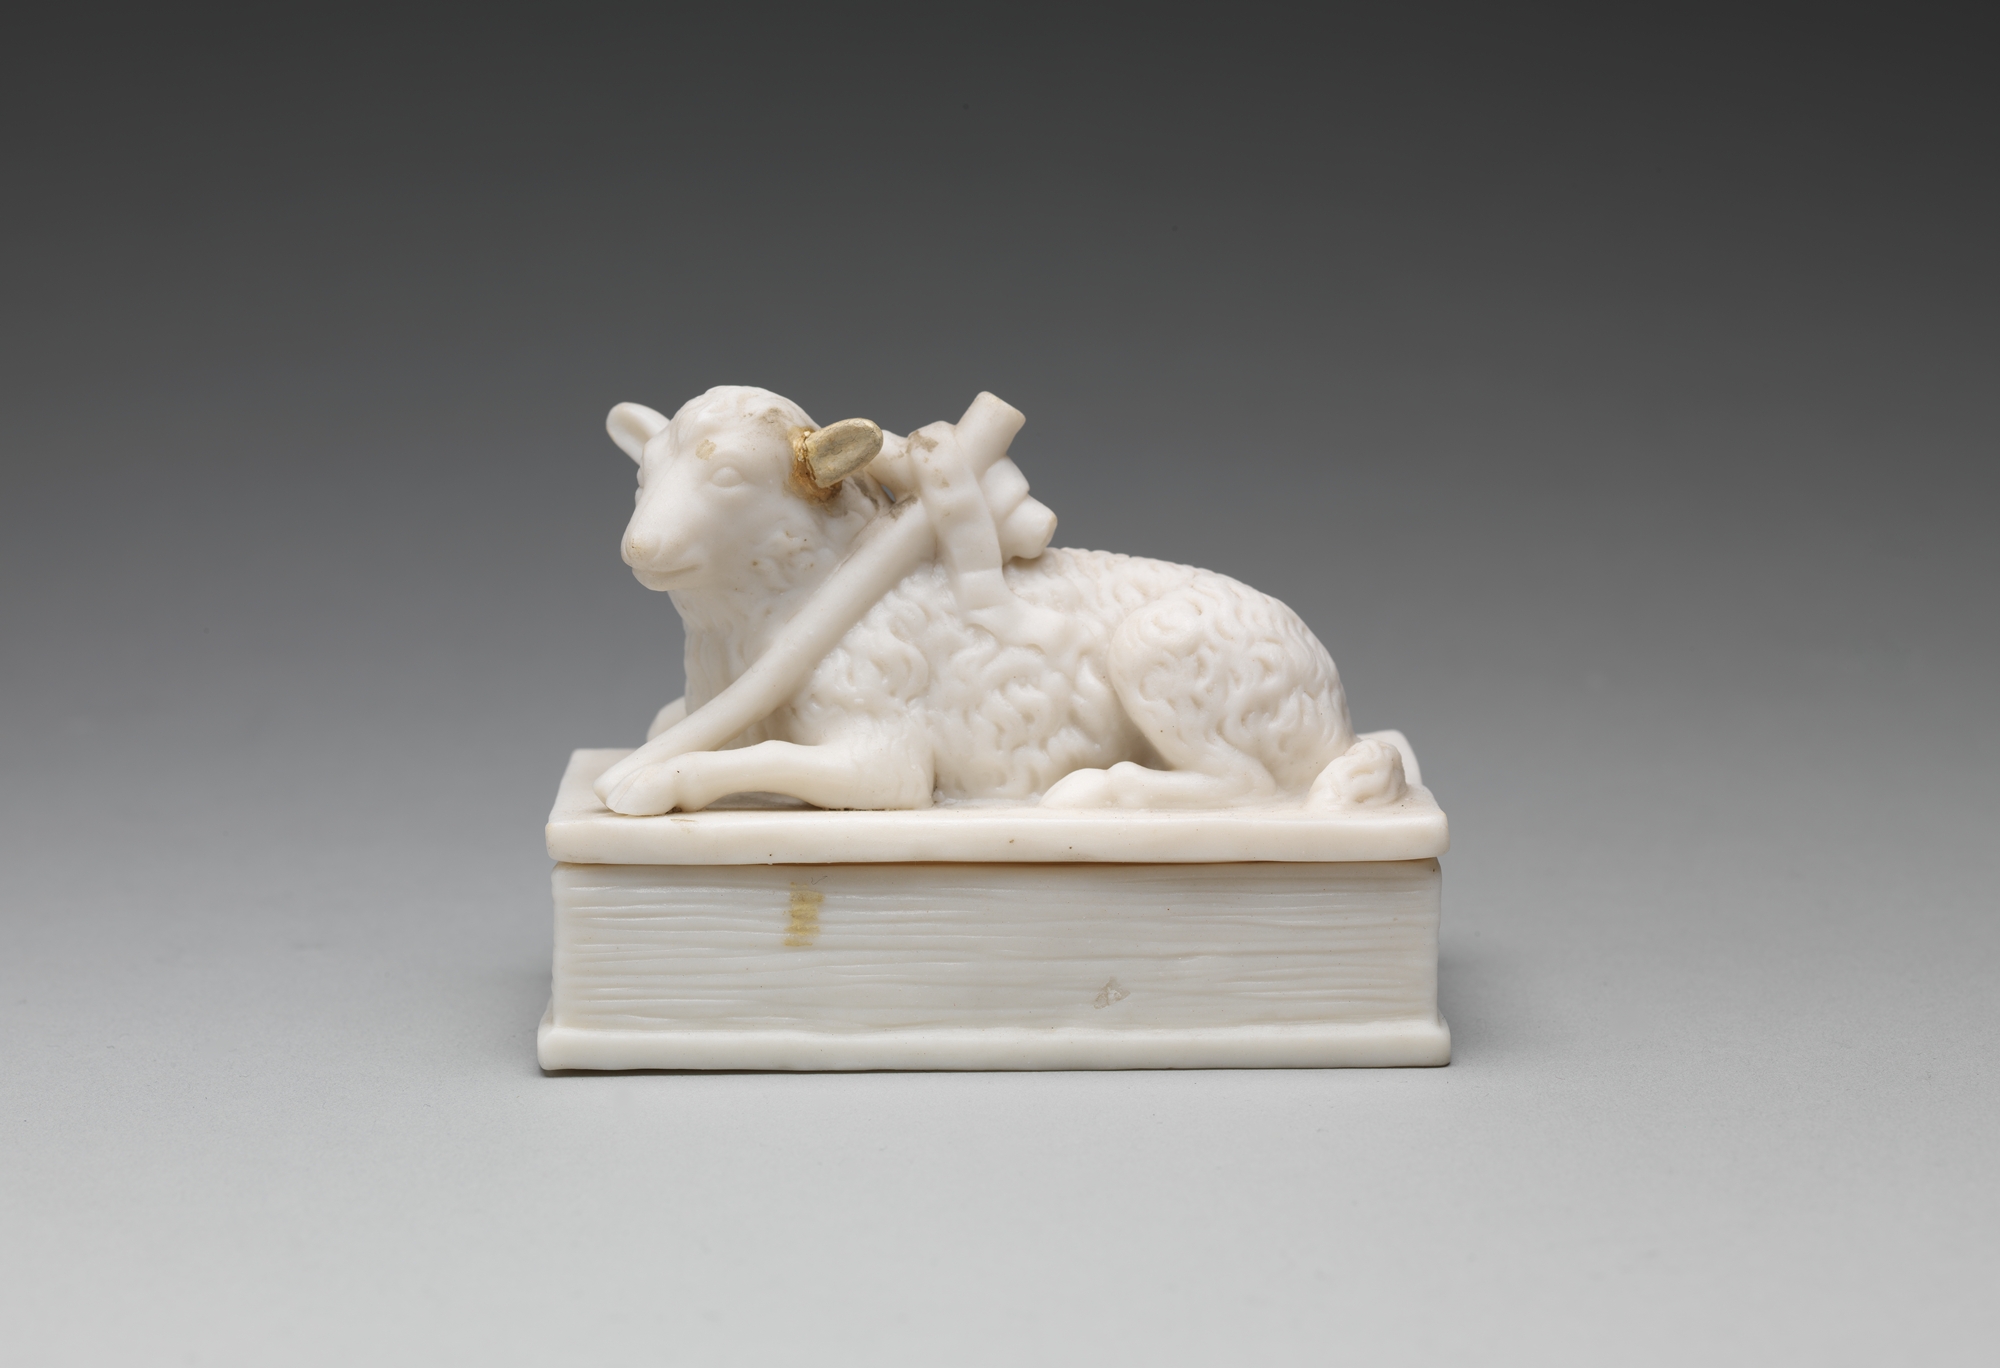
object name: box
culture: american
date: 1830-1870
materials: porcelain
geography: united states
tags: lambs